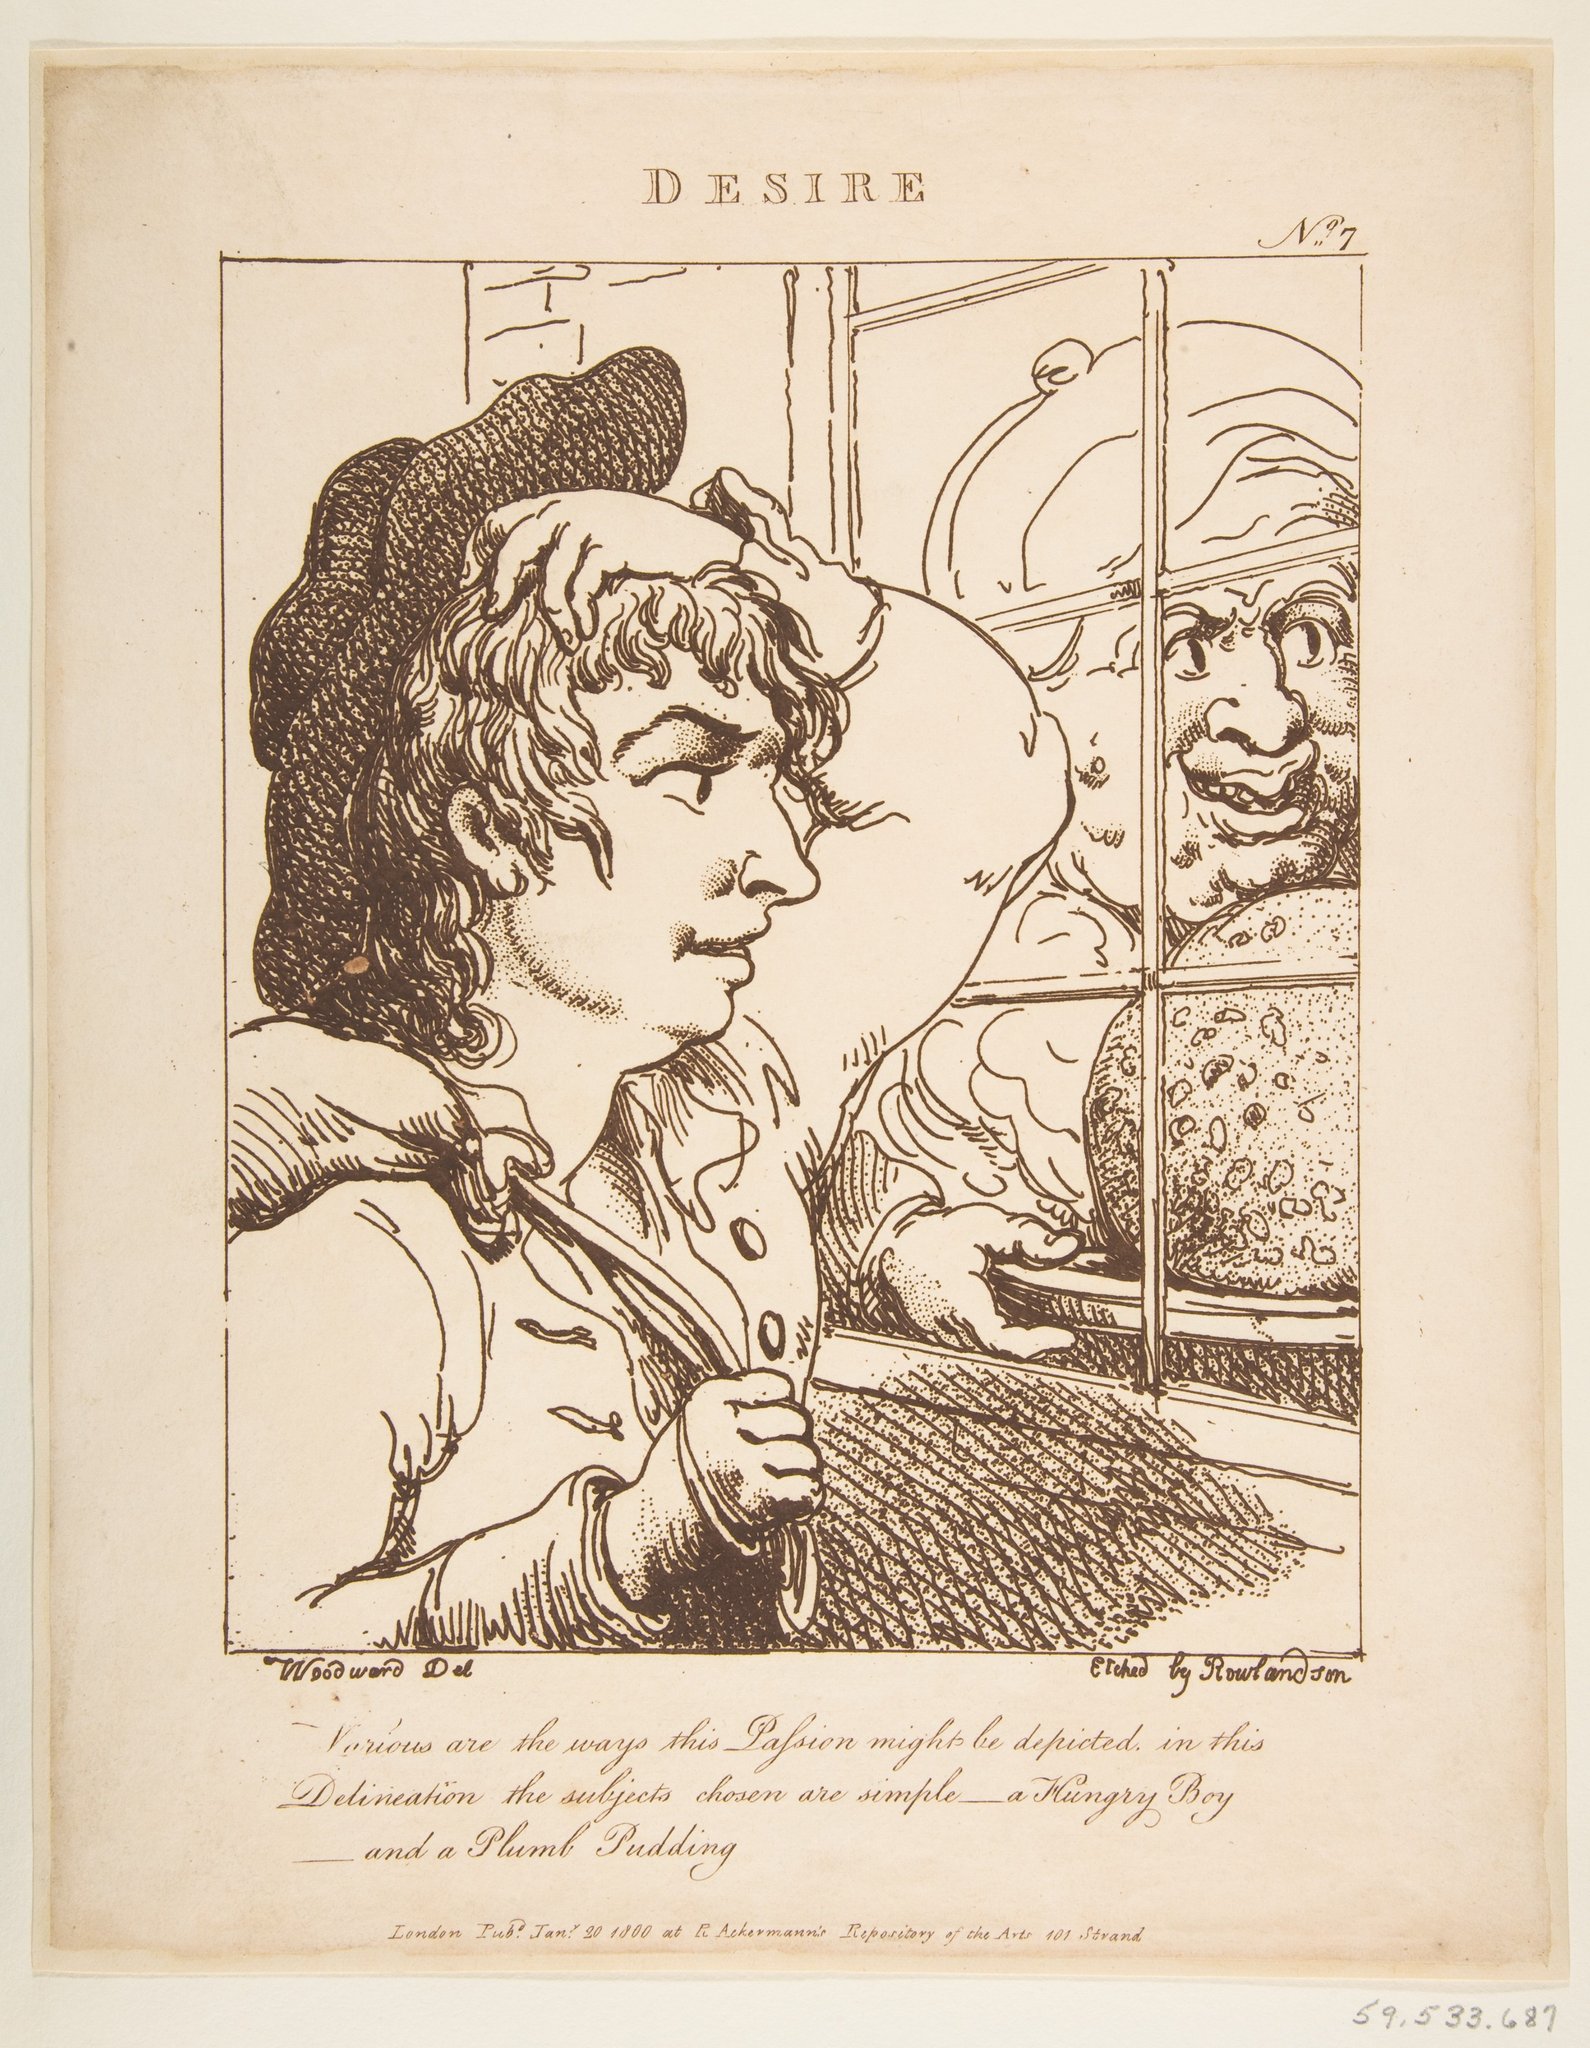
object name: print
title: Desire (Le Brun Travested, or Caricatures of the Passions)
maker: thomas rowlandson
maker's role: artist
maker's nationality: british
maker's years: 1757-1827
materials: ink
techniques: etching, printing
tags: food,satire,boys